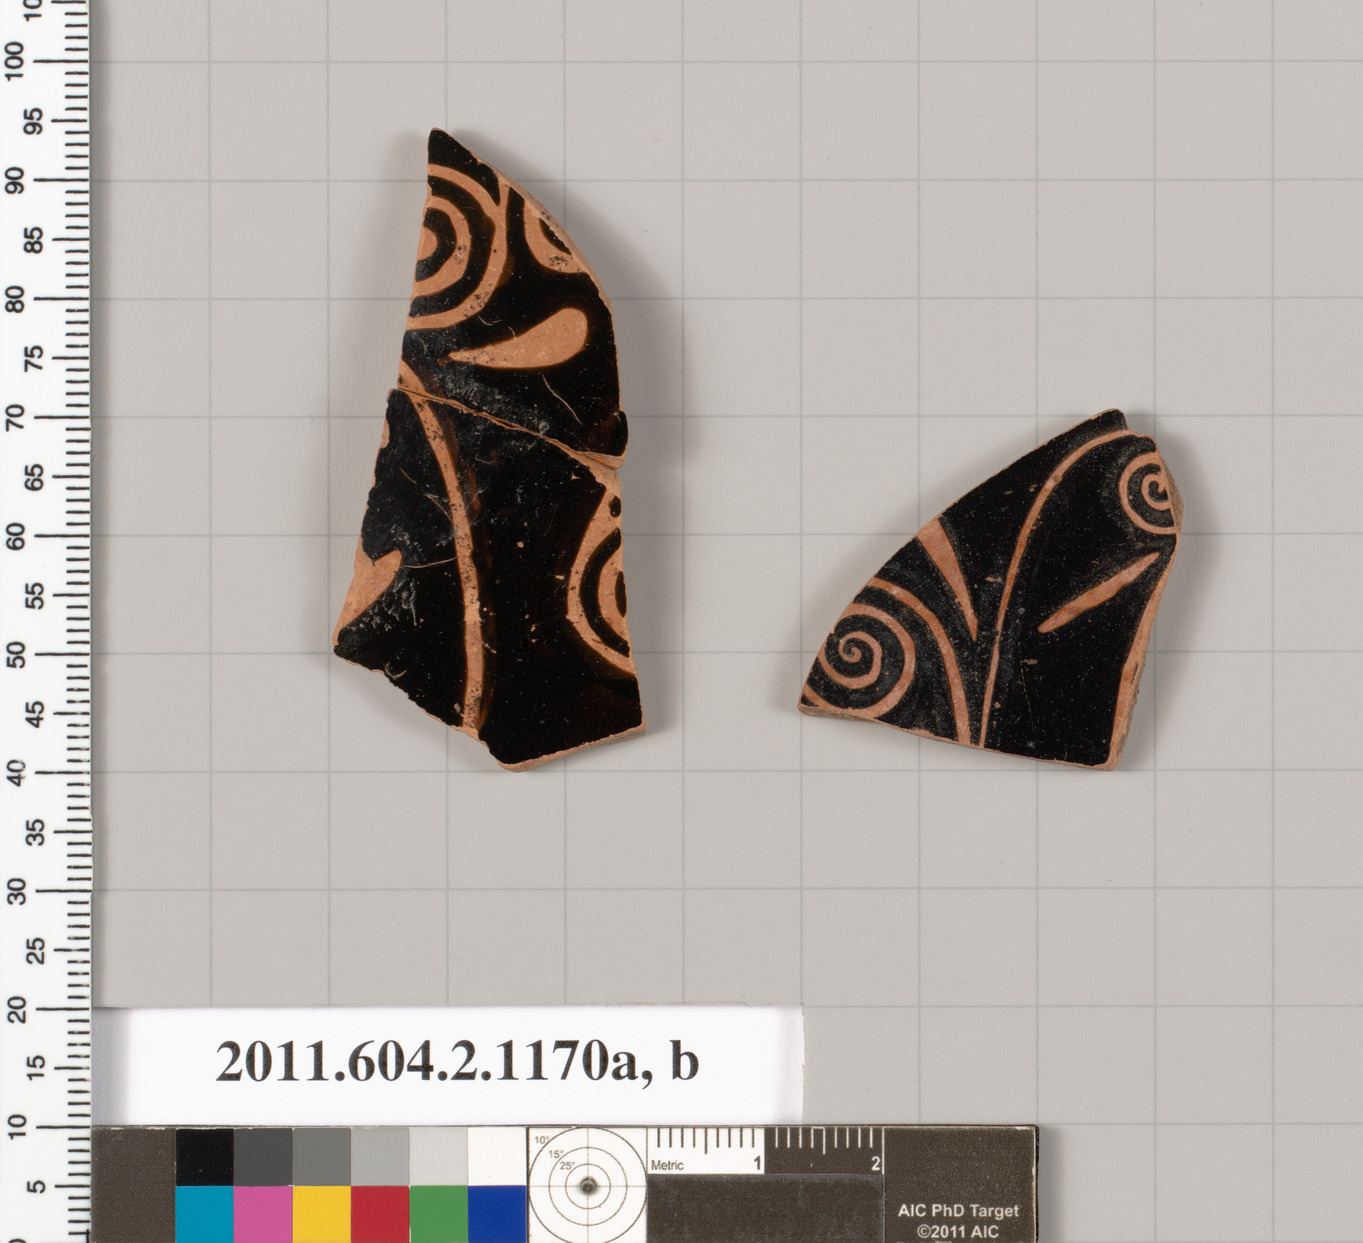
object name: skyphos fragment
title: Terracotta fragments of skyphoi (deep drinking cups)?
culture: greek, attic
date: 475-451 BCE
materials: terracotta